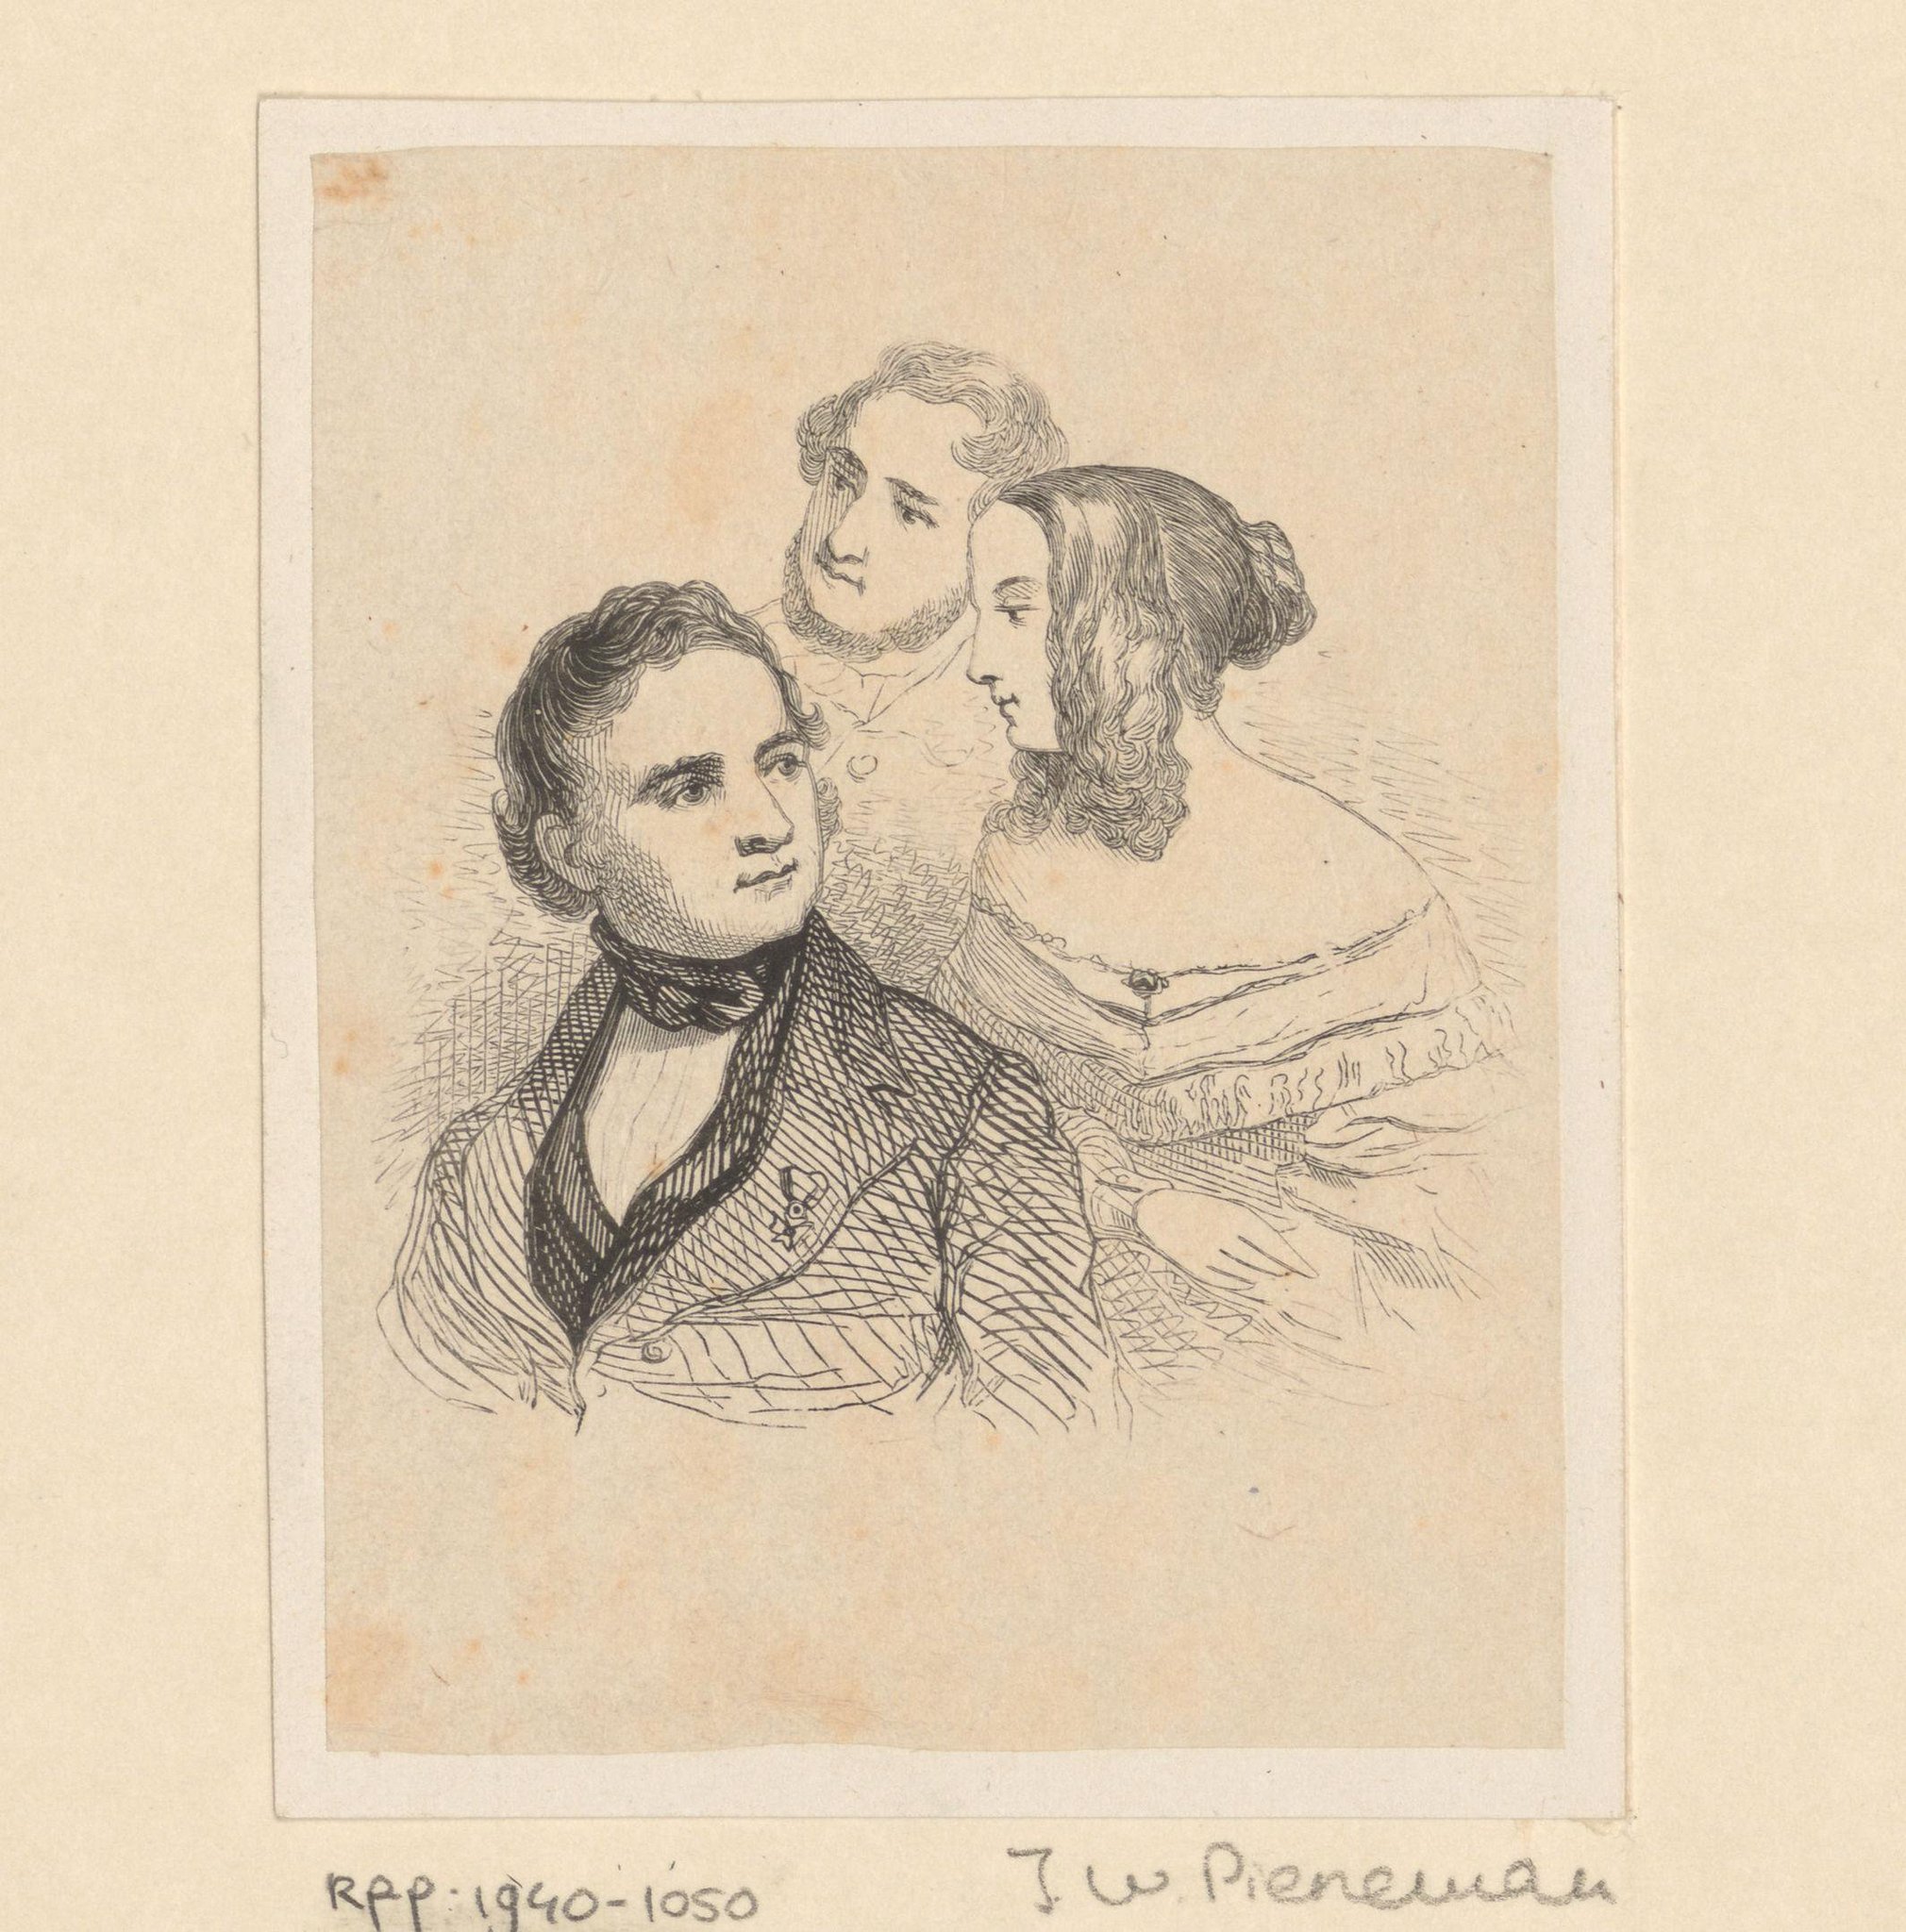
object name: print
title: Portret van Jan Willem Pieneman met zijn zoon en dochter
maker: Anonymous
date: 1825-1899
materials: paper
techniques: engraving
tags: abcoude, jan willem pieneman, draughtsman, nicolaas pieneman, adolescent, young woman, maiden, adult man, historical persons, youth, adolescent, artist (in general)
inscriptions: collector's mark: Lugt 2760, collector's mark: Lugt 2228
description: Waarschijnlijk gaat het om een zelfportret van Jan Wilem Pieneman met zijn zoon, Nicolaas Pieneman, en een van zijn dochters, Clasina Henriette of Frederica Wilhelmina Margaretha.